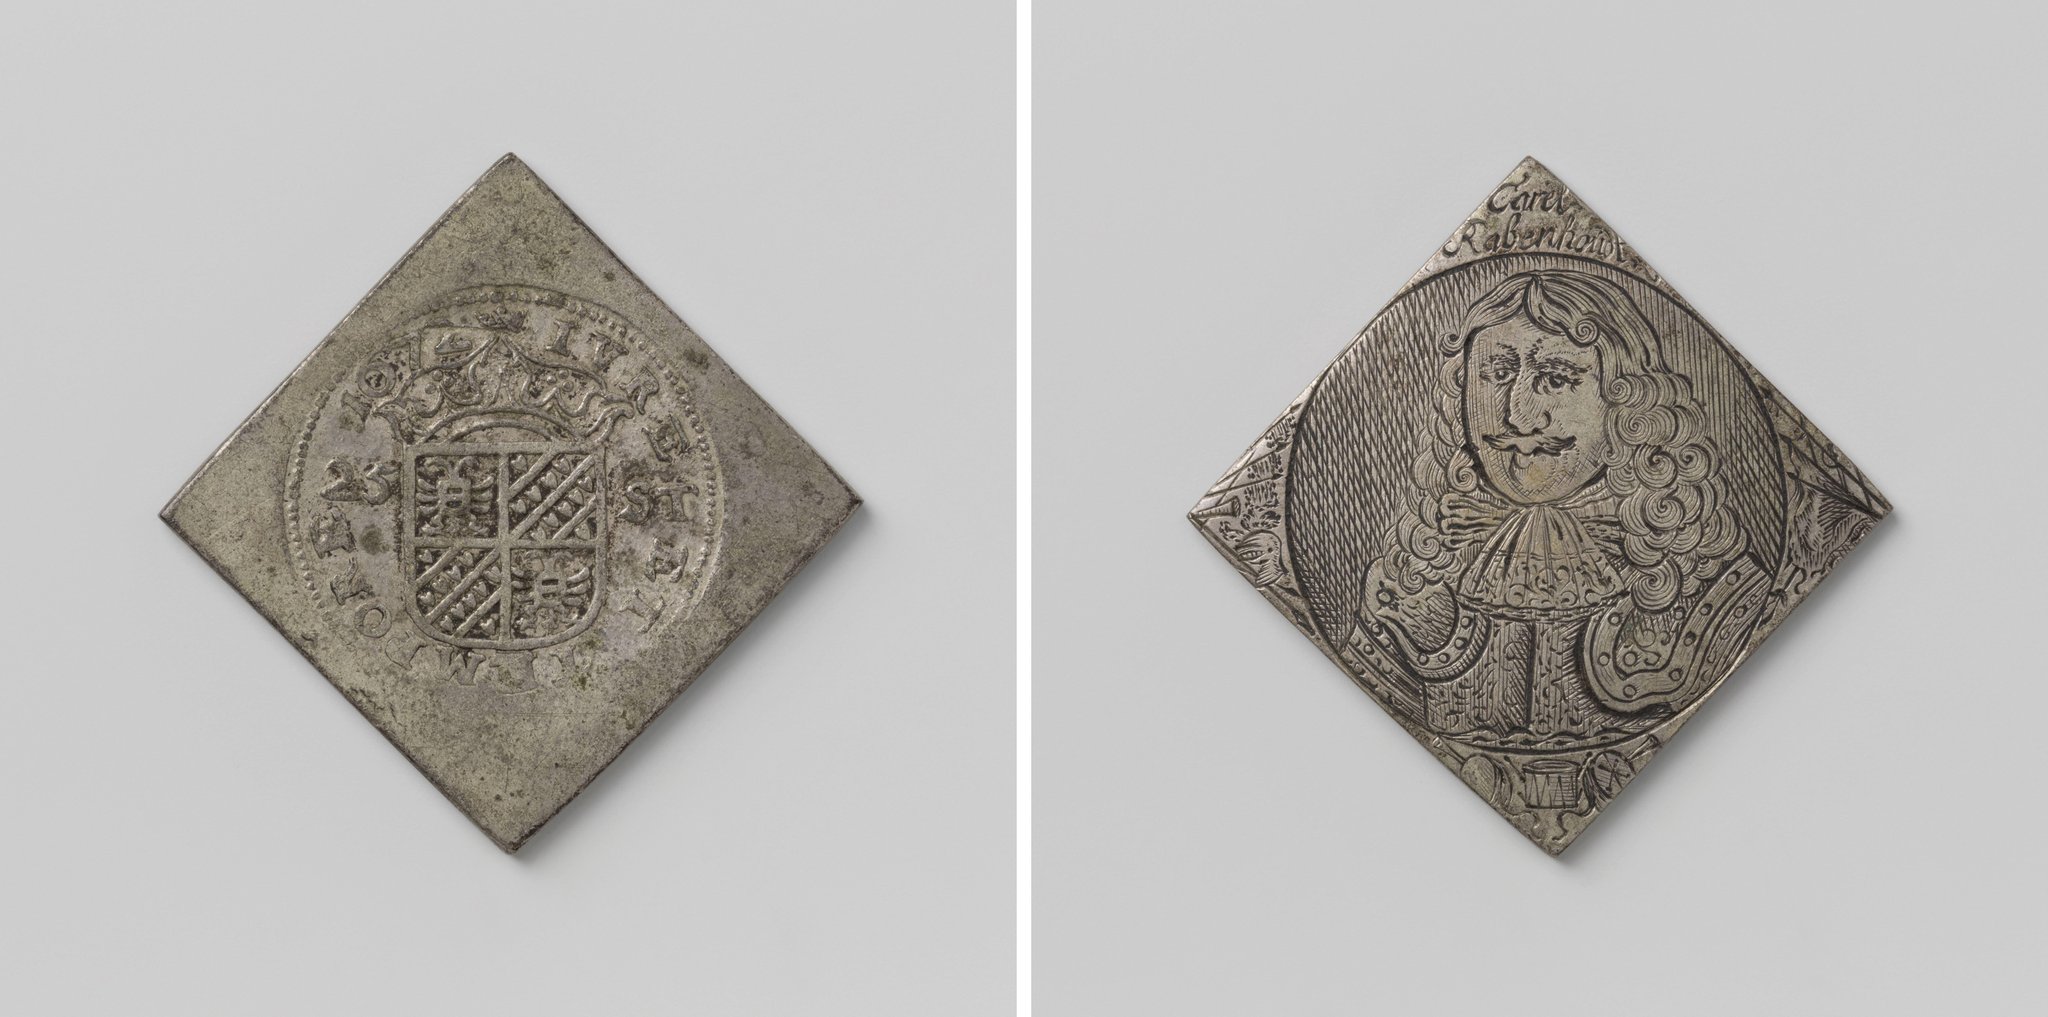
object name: halve daalder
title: Halve daalder, noodmunt uit Groningen, geslagen tijdens het beleg (voorzien van het portret van Karl Rabenhaupt)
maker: Anonymous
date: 1672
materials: silver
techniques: engraving, striking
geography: groningen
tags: bohemen, coevorden, gouverneur, karl rabenhaupt (baron von sucha), groningen, beleg van groningen (1672)